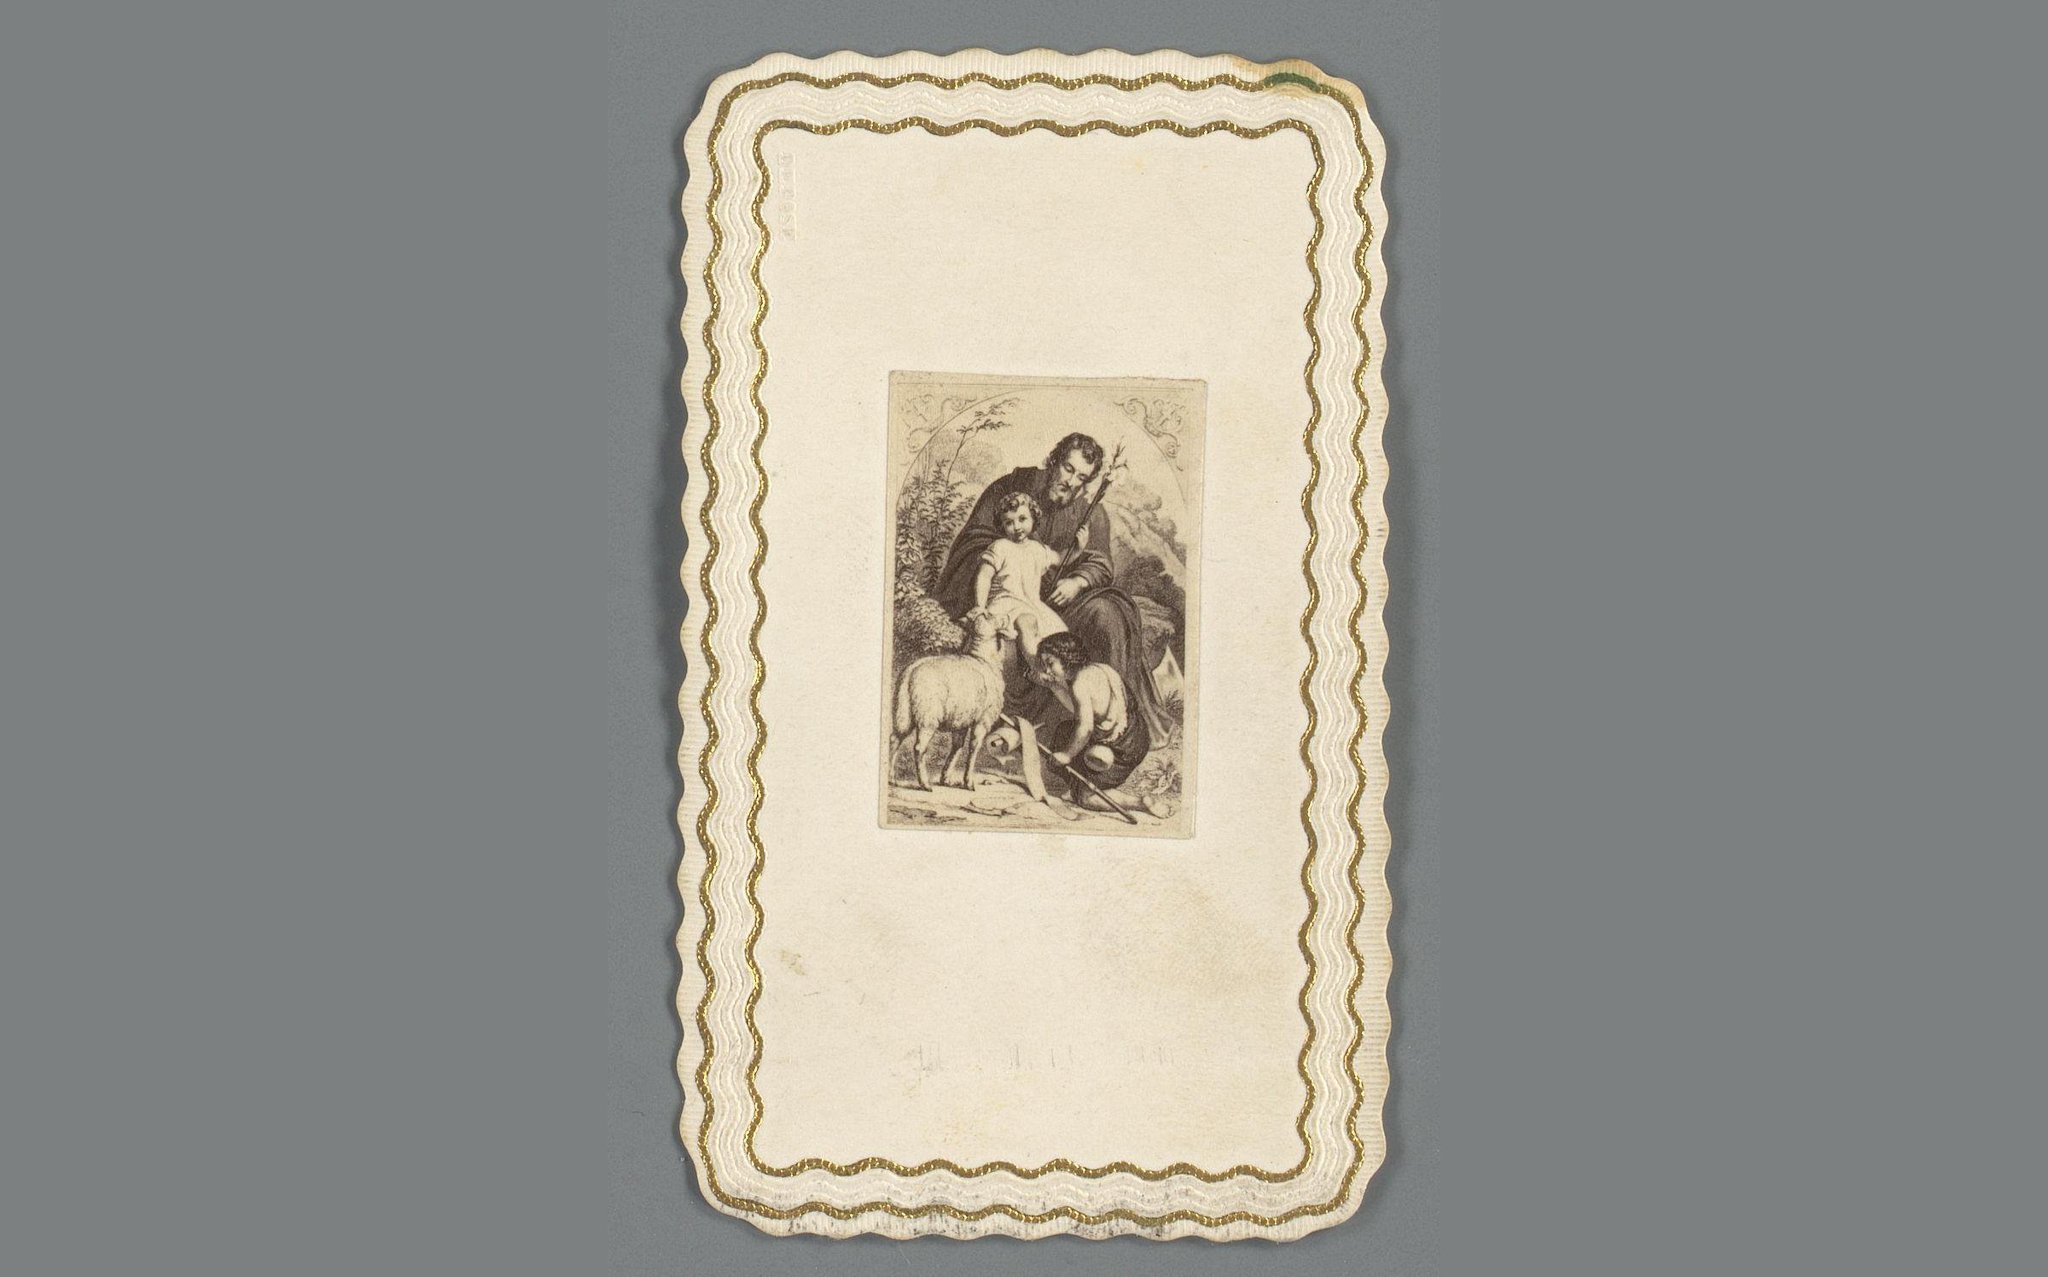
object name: prayer card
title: Fotoreproductie van een schilderij van Jozef, Christus en Johannes de Doper op bidprent ter gelegenheid van een Eerste Communie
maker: Anonymous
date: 1869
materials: cardboard, paper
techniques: albumen print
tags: sheep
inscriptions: inscription: ‘Souvenir du R.P./ Georgin lejour/ De ma receptions/ Dans la congregations/ du St.enfant Jesus/ le 3 Mars 1869.’